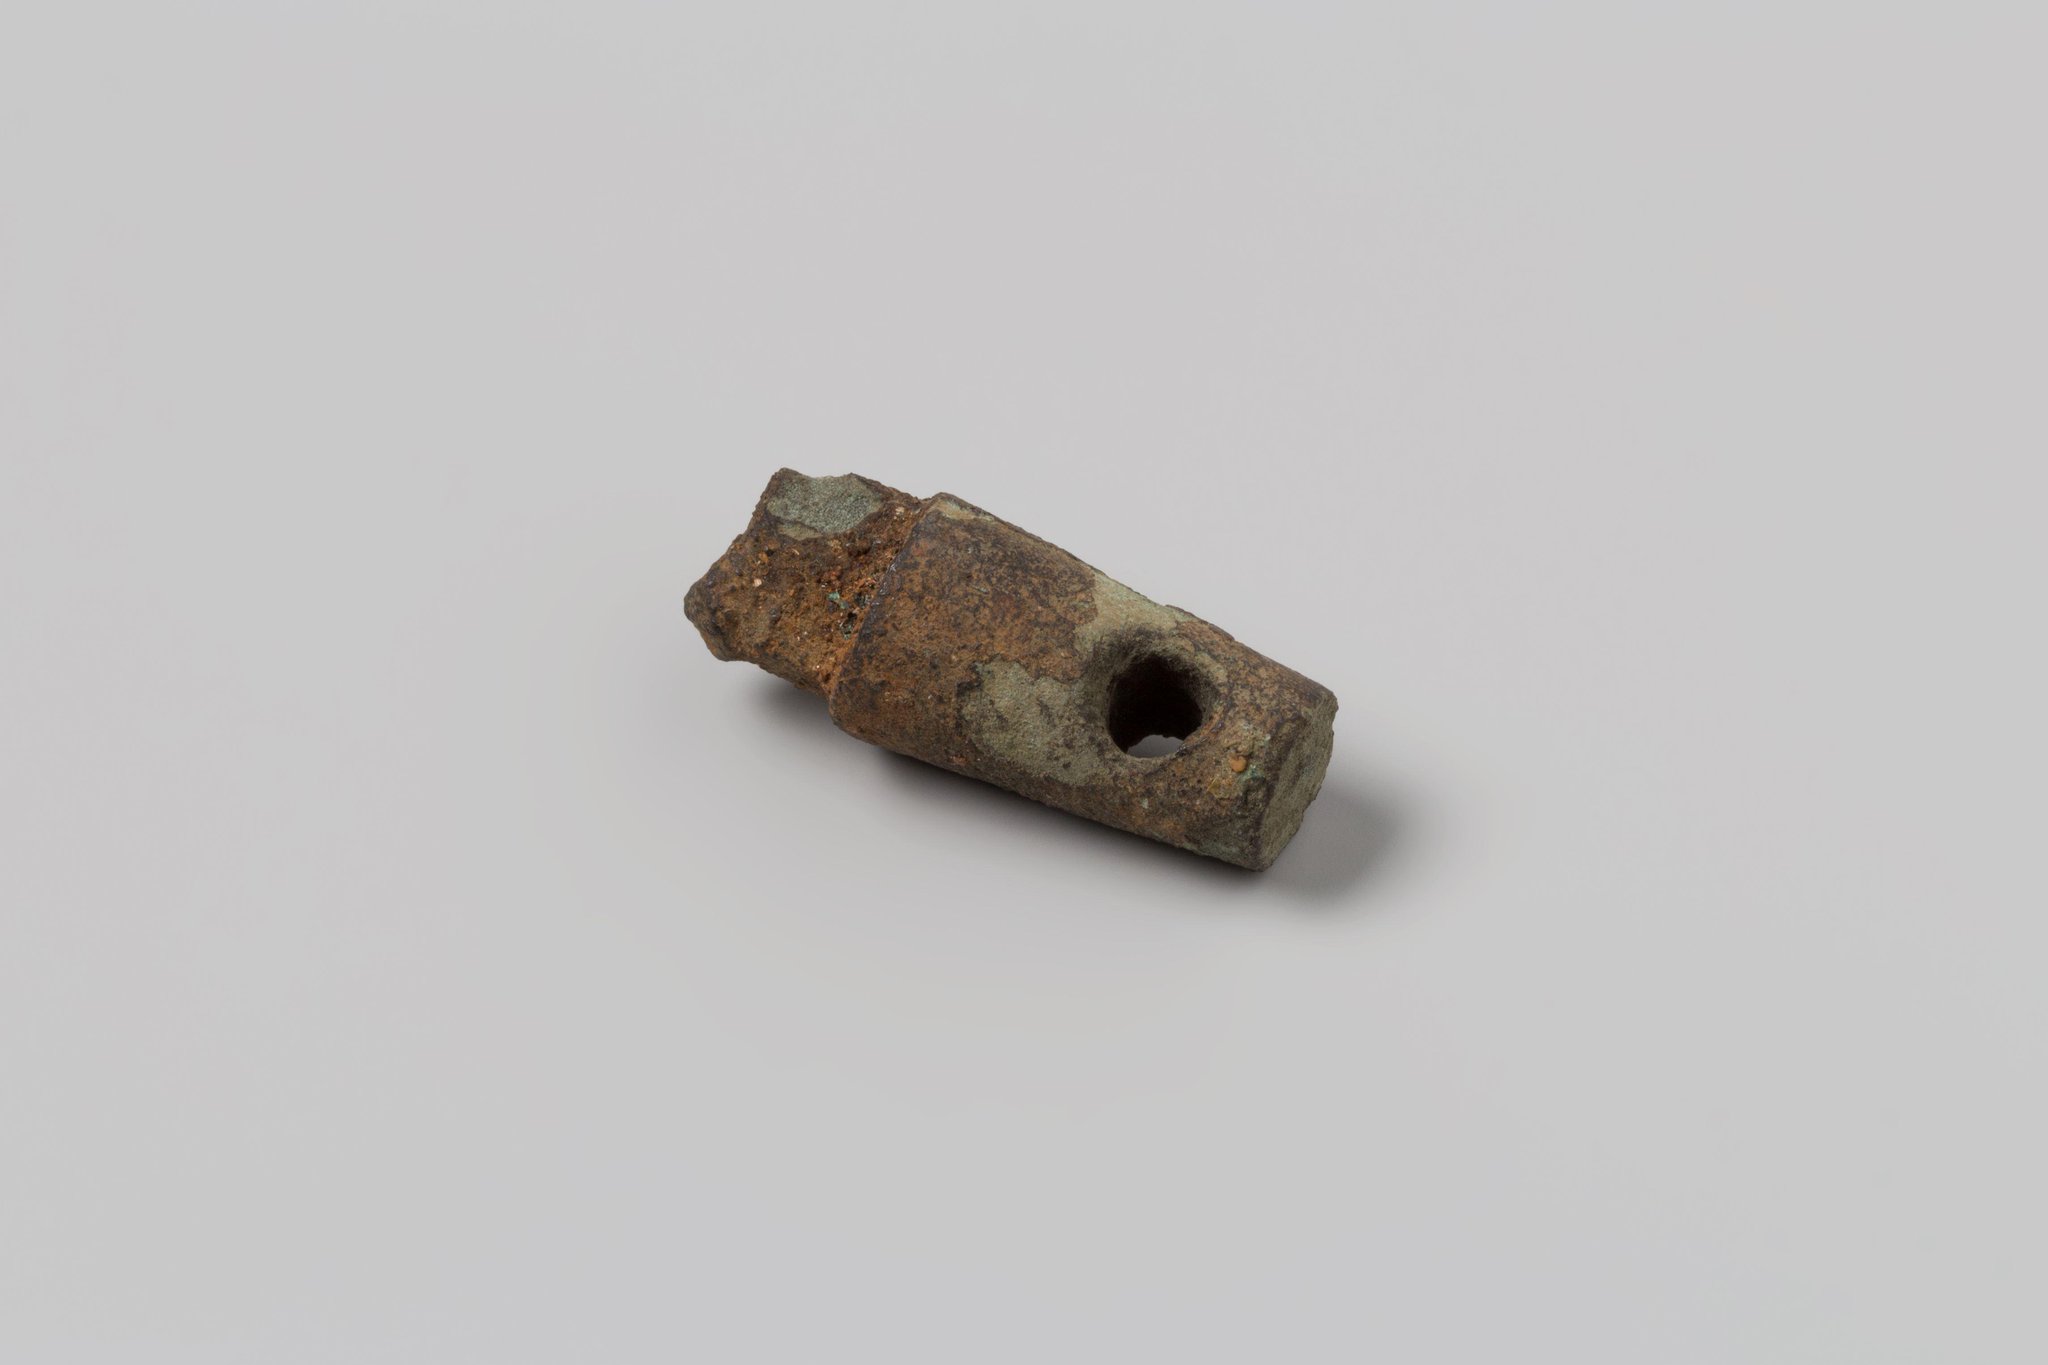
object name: spigot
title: Onderdeel tapkraan uit het wrak van de Oost-Indiëvaarder Hollandia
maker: Anonymous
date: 1700-1743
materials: copper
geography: netherlands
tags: verenigde oostindische compagnie, hollandia (schip), annet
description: Tap, spigot, removable; fragm, sim. NG 1980-27H903, handle missing, no arrester lug, corroded.